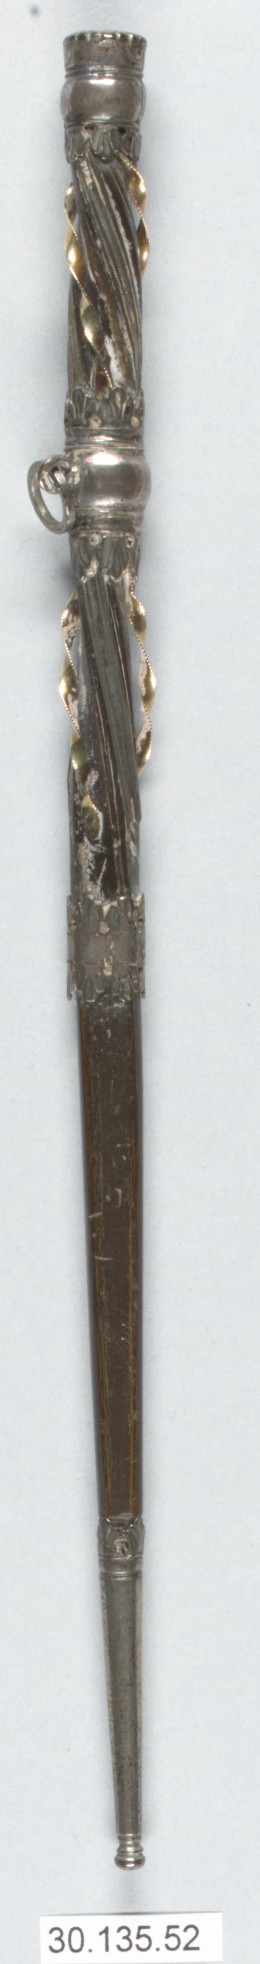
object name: needle sheath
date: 1601-1800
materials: horn, metal